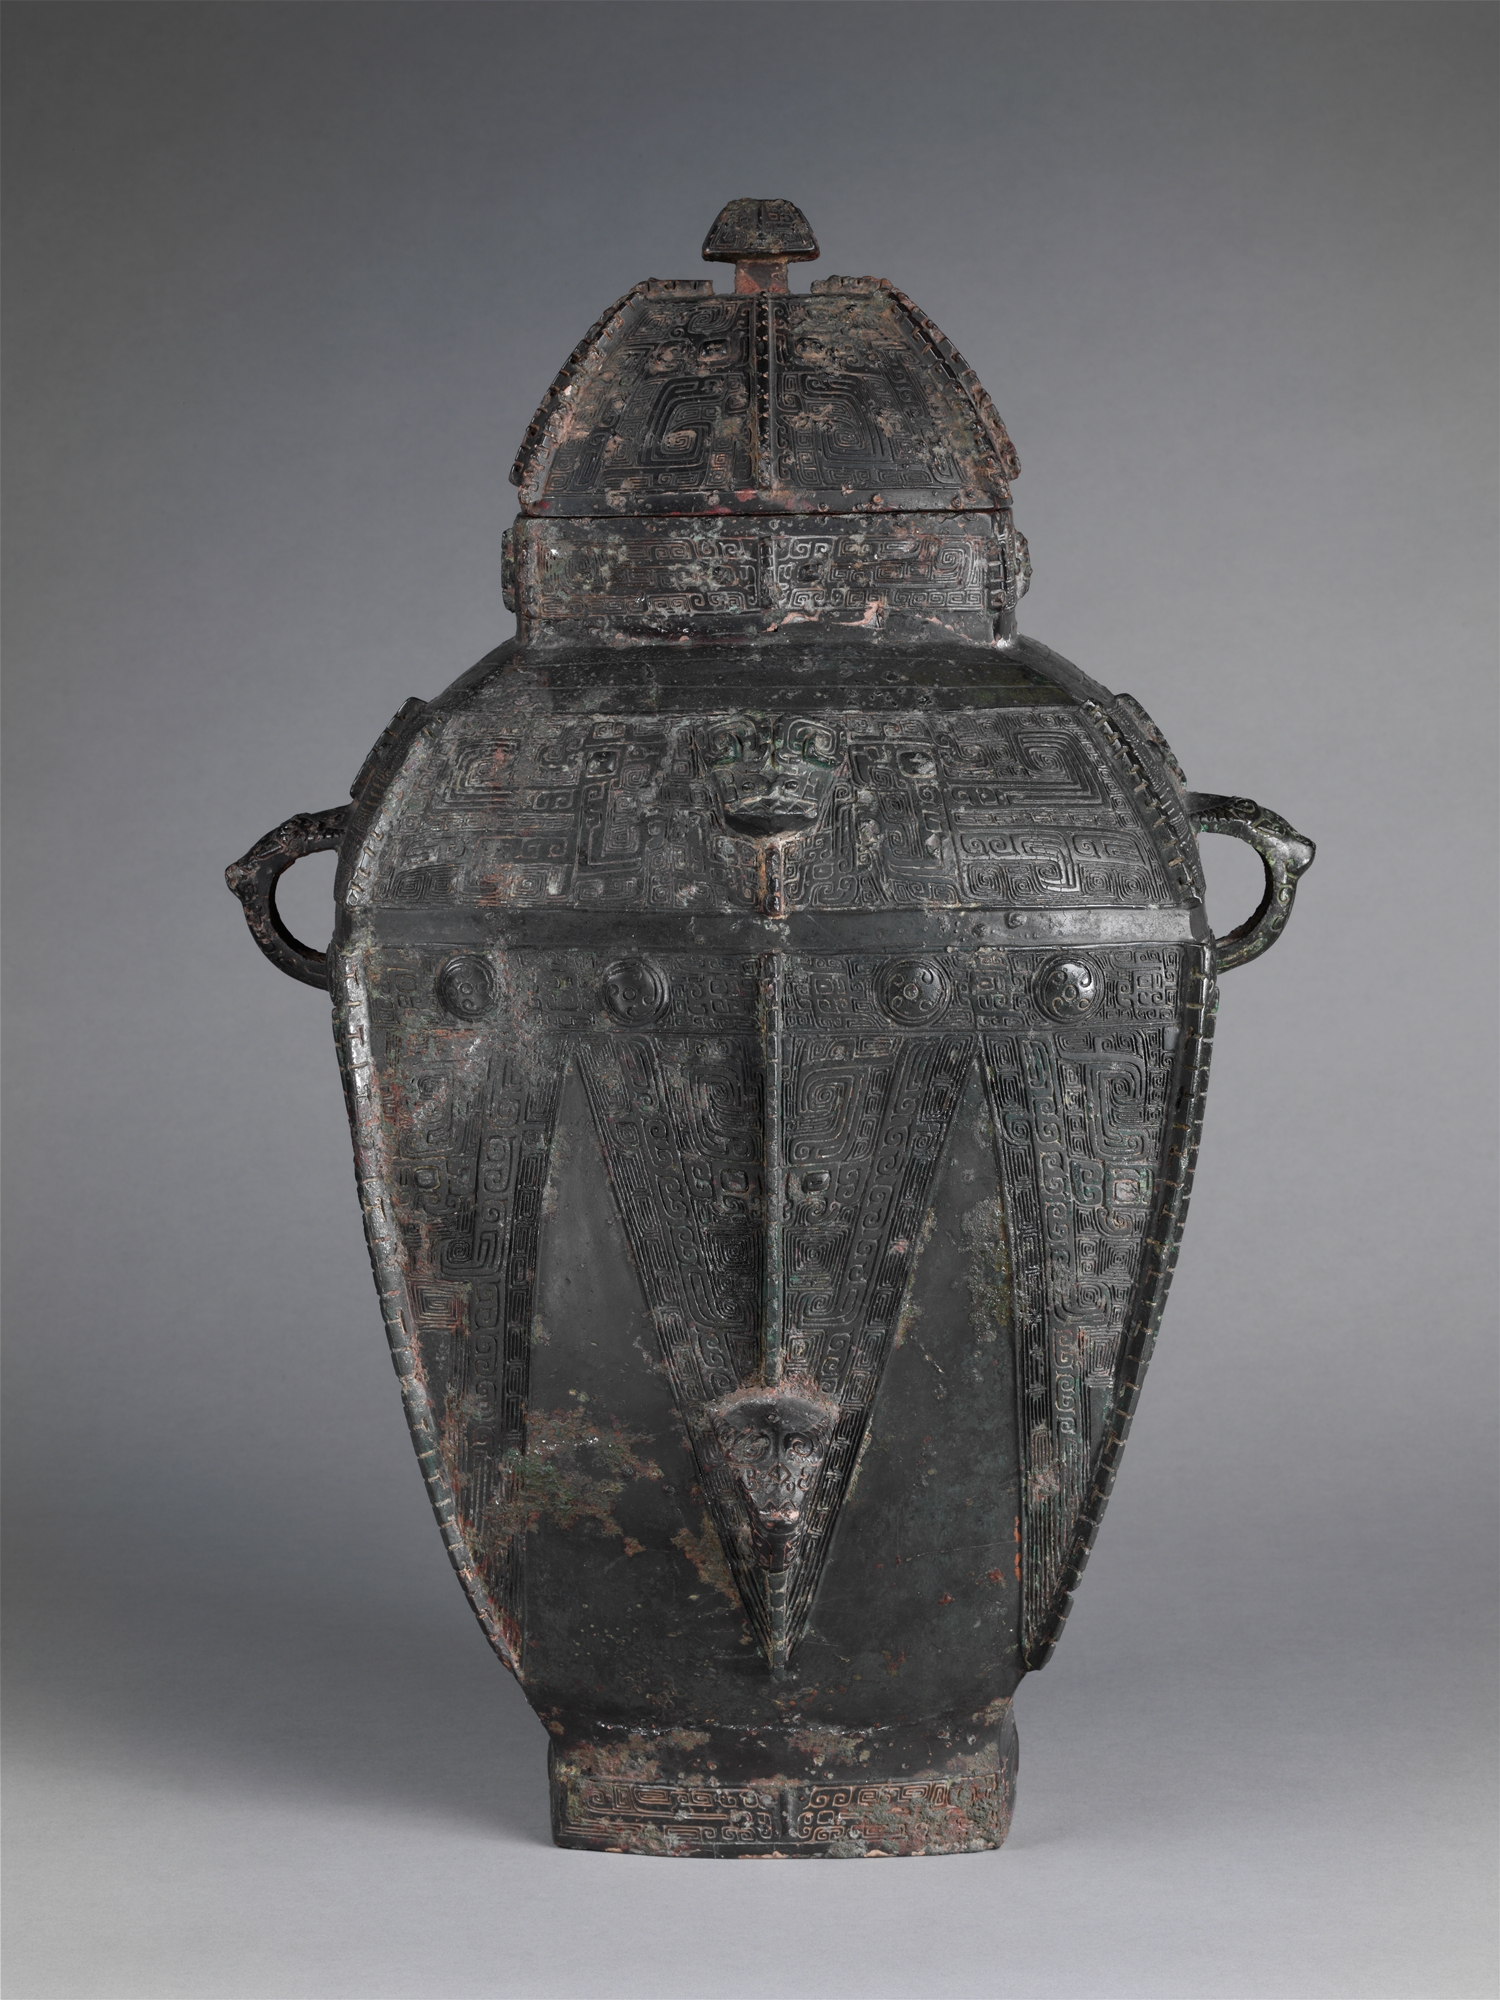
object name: wine container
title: Rectangular wine container (fanglei)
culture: chinese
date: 1300-1201 BCE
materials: bronze